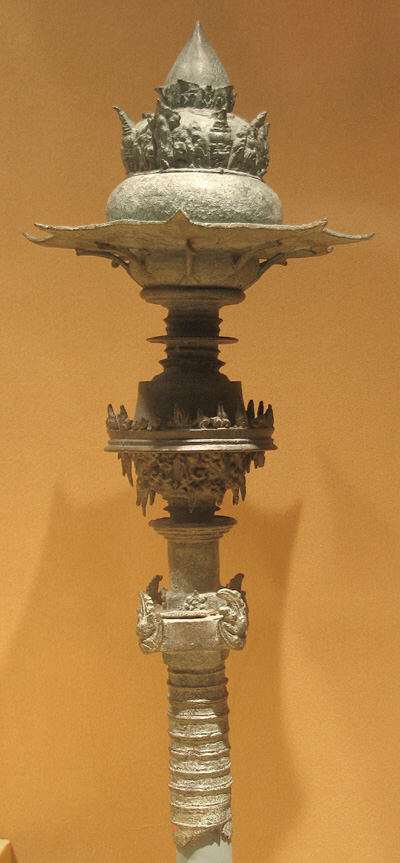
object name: scepter top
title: Top of a Scepter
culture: indonesian, javanese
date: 1251-1300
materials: copper alloy